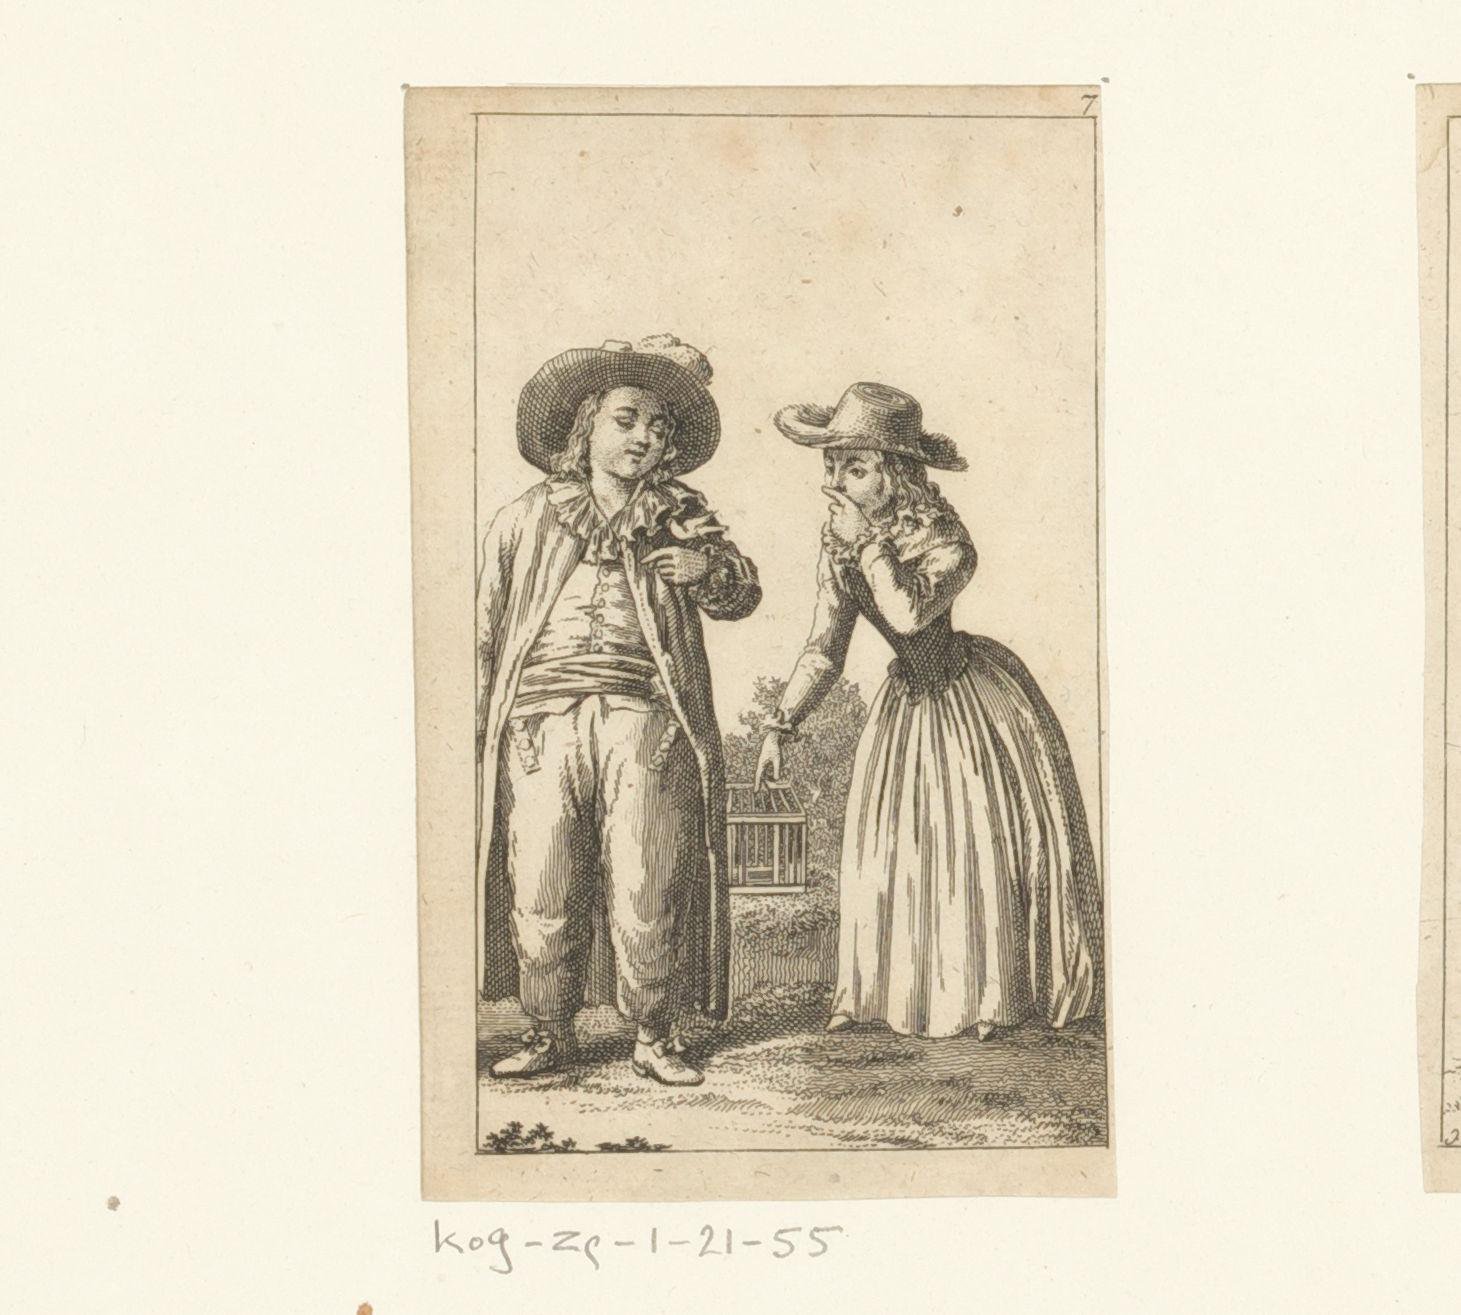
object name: print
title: Jongen en meisje met een vogelkooi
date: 1780-1840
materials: paper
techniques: etching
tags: empty bird cage, boy (child between toddler and youth), girl (child between toddler and youth), head-gear: hat, dress, gown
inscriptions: stamp, collector's mark: Lugt 1641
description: Rechtsboven genummerd: 7. Onderwerpsrubrieken binnen de Atlas Zeden en Gewoonten: Zeden en Gewoonten in Engeren Zin, De Kleeding, Kleederdrachten (tijdvakken), De 18de eeuw (de pruikentijd). Mannen en vrouwen.